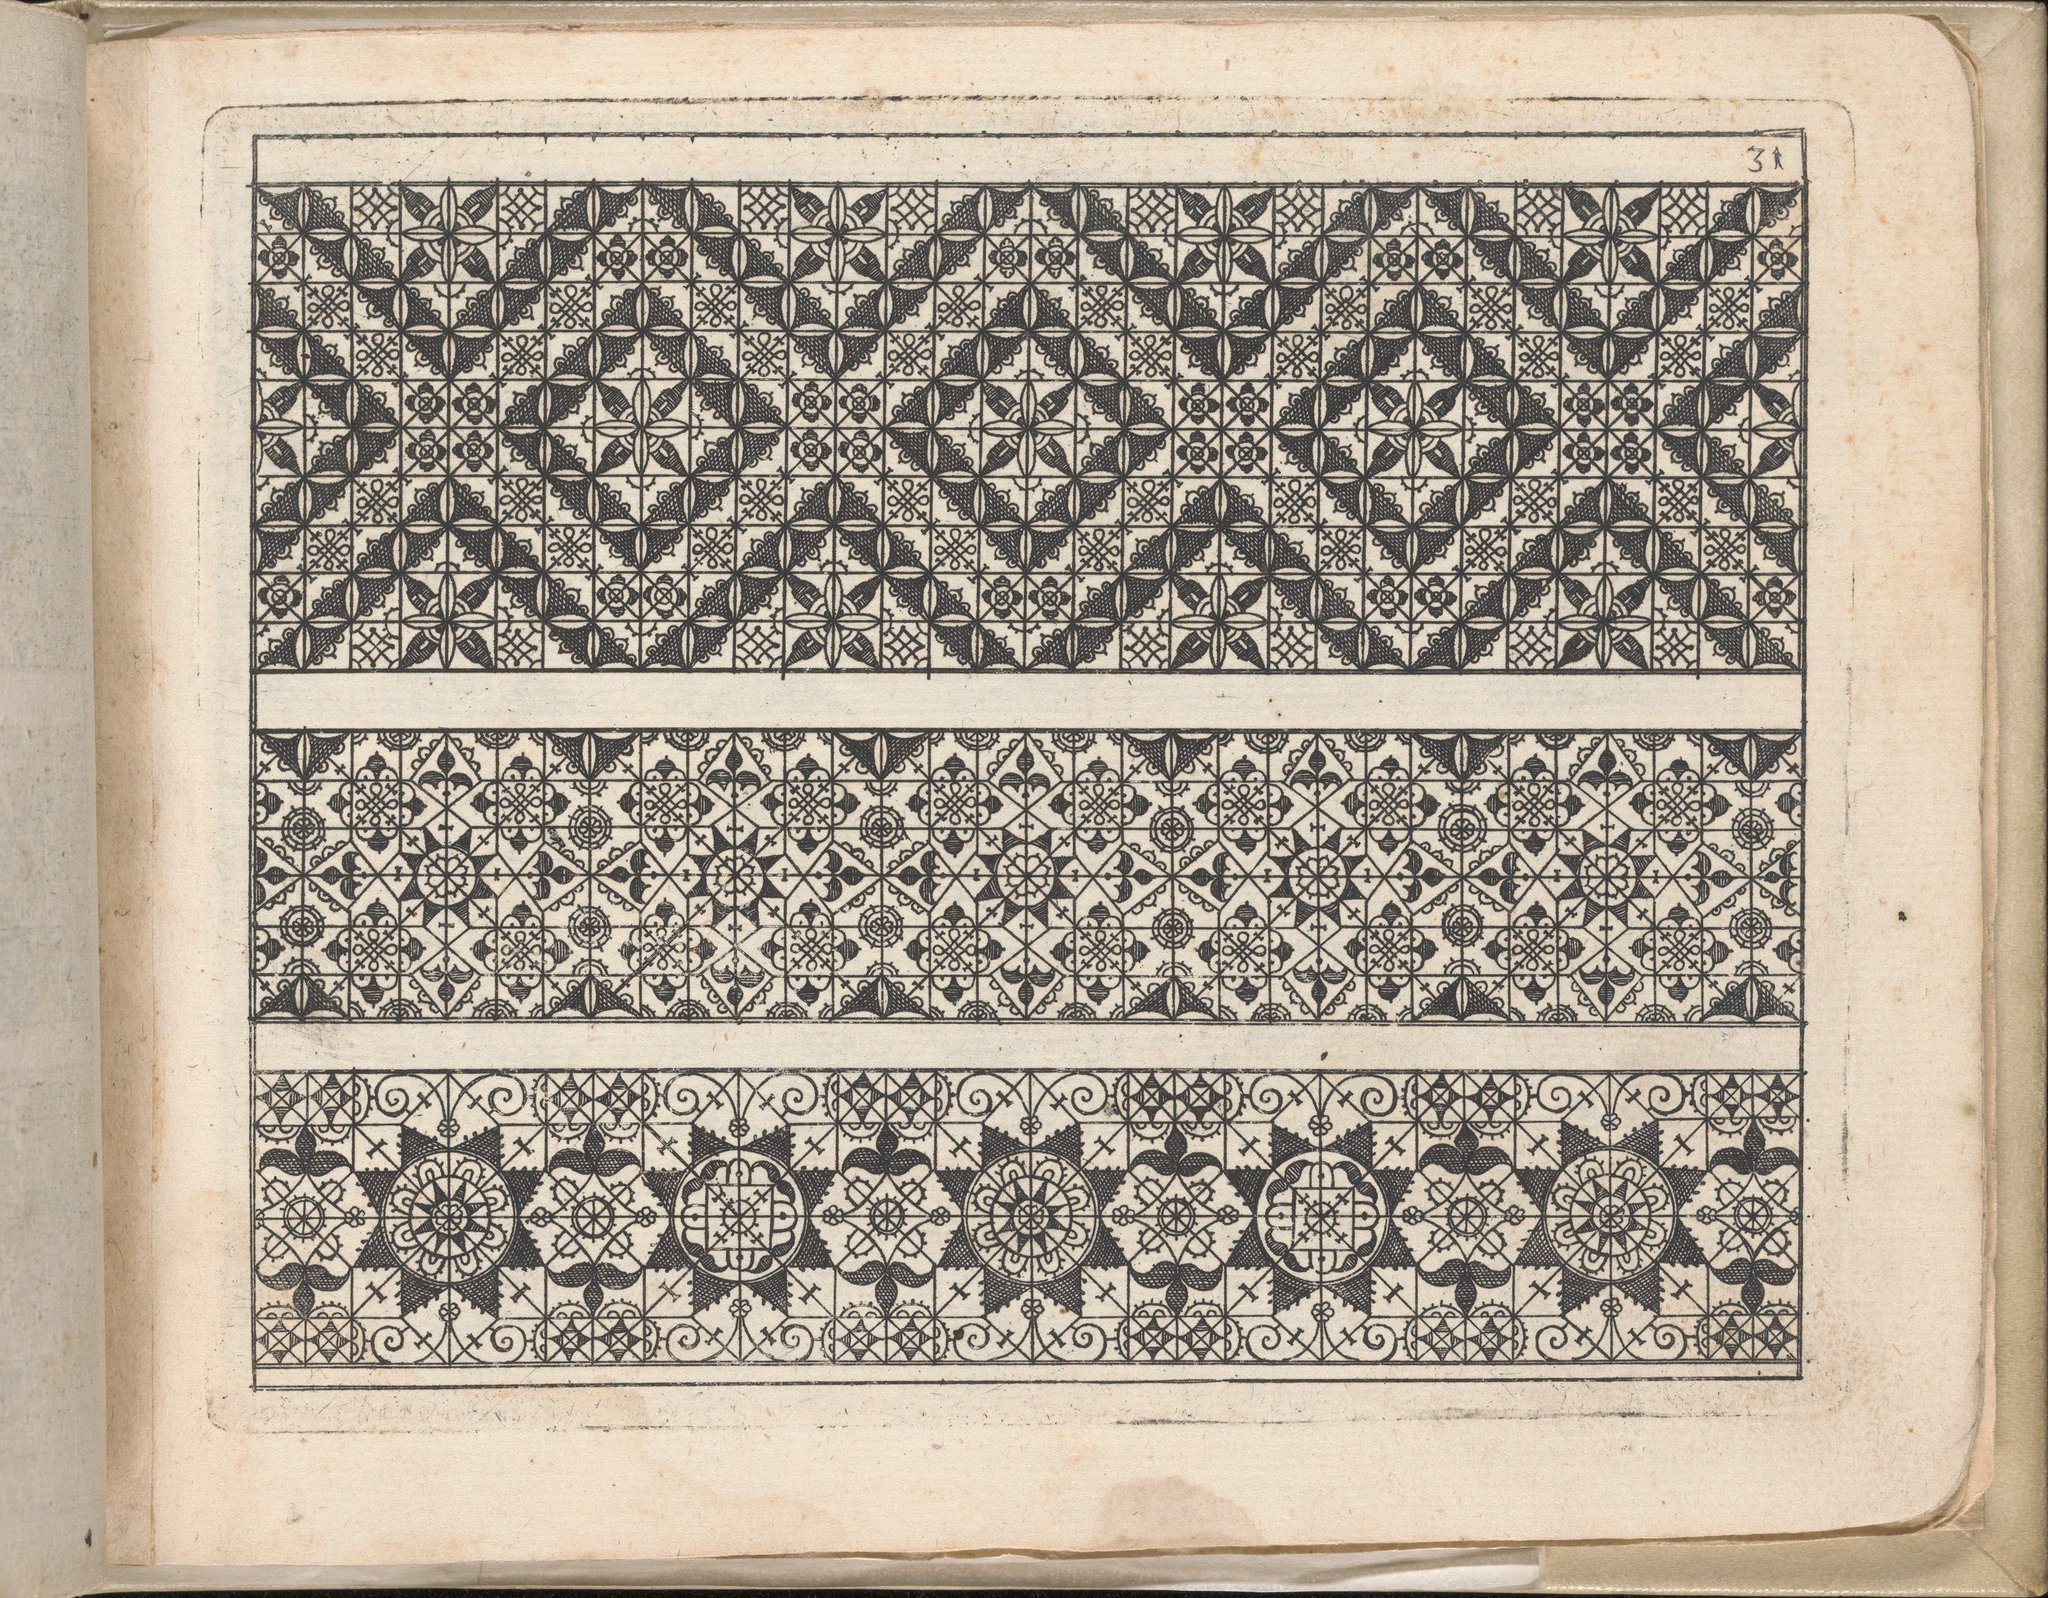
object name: book print ornament architecture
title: Schön Neues Modelbuch (Page 36 recto)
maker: johann sibmacher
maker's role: designer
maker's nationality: german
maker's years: 1590-1611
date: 1597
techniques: etching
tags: ornament